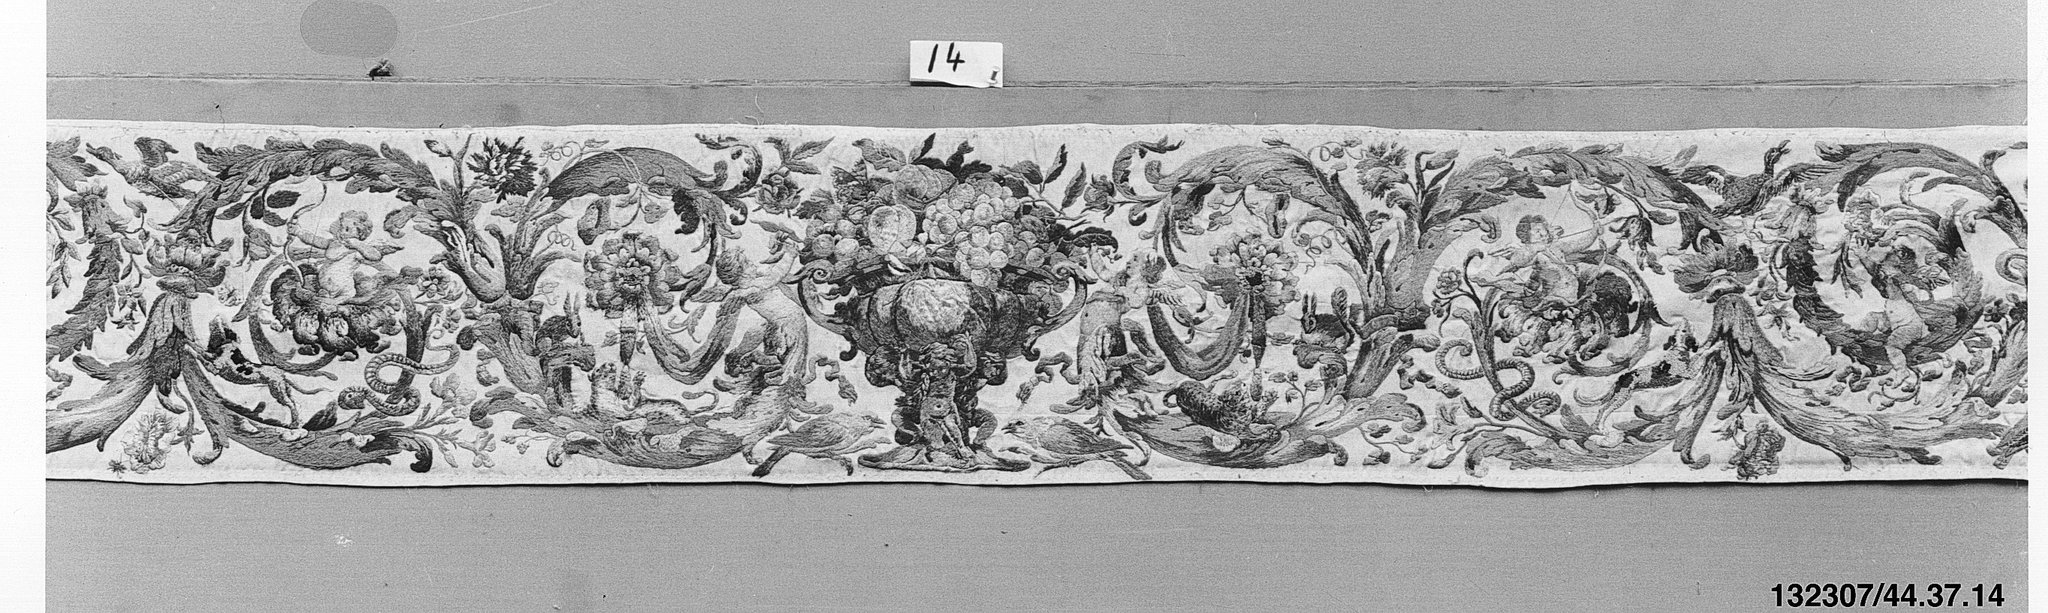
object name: valance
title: Valance (one of a set of six)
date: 1667-1733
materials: silk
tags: cupid,flowers